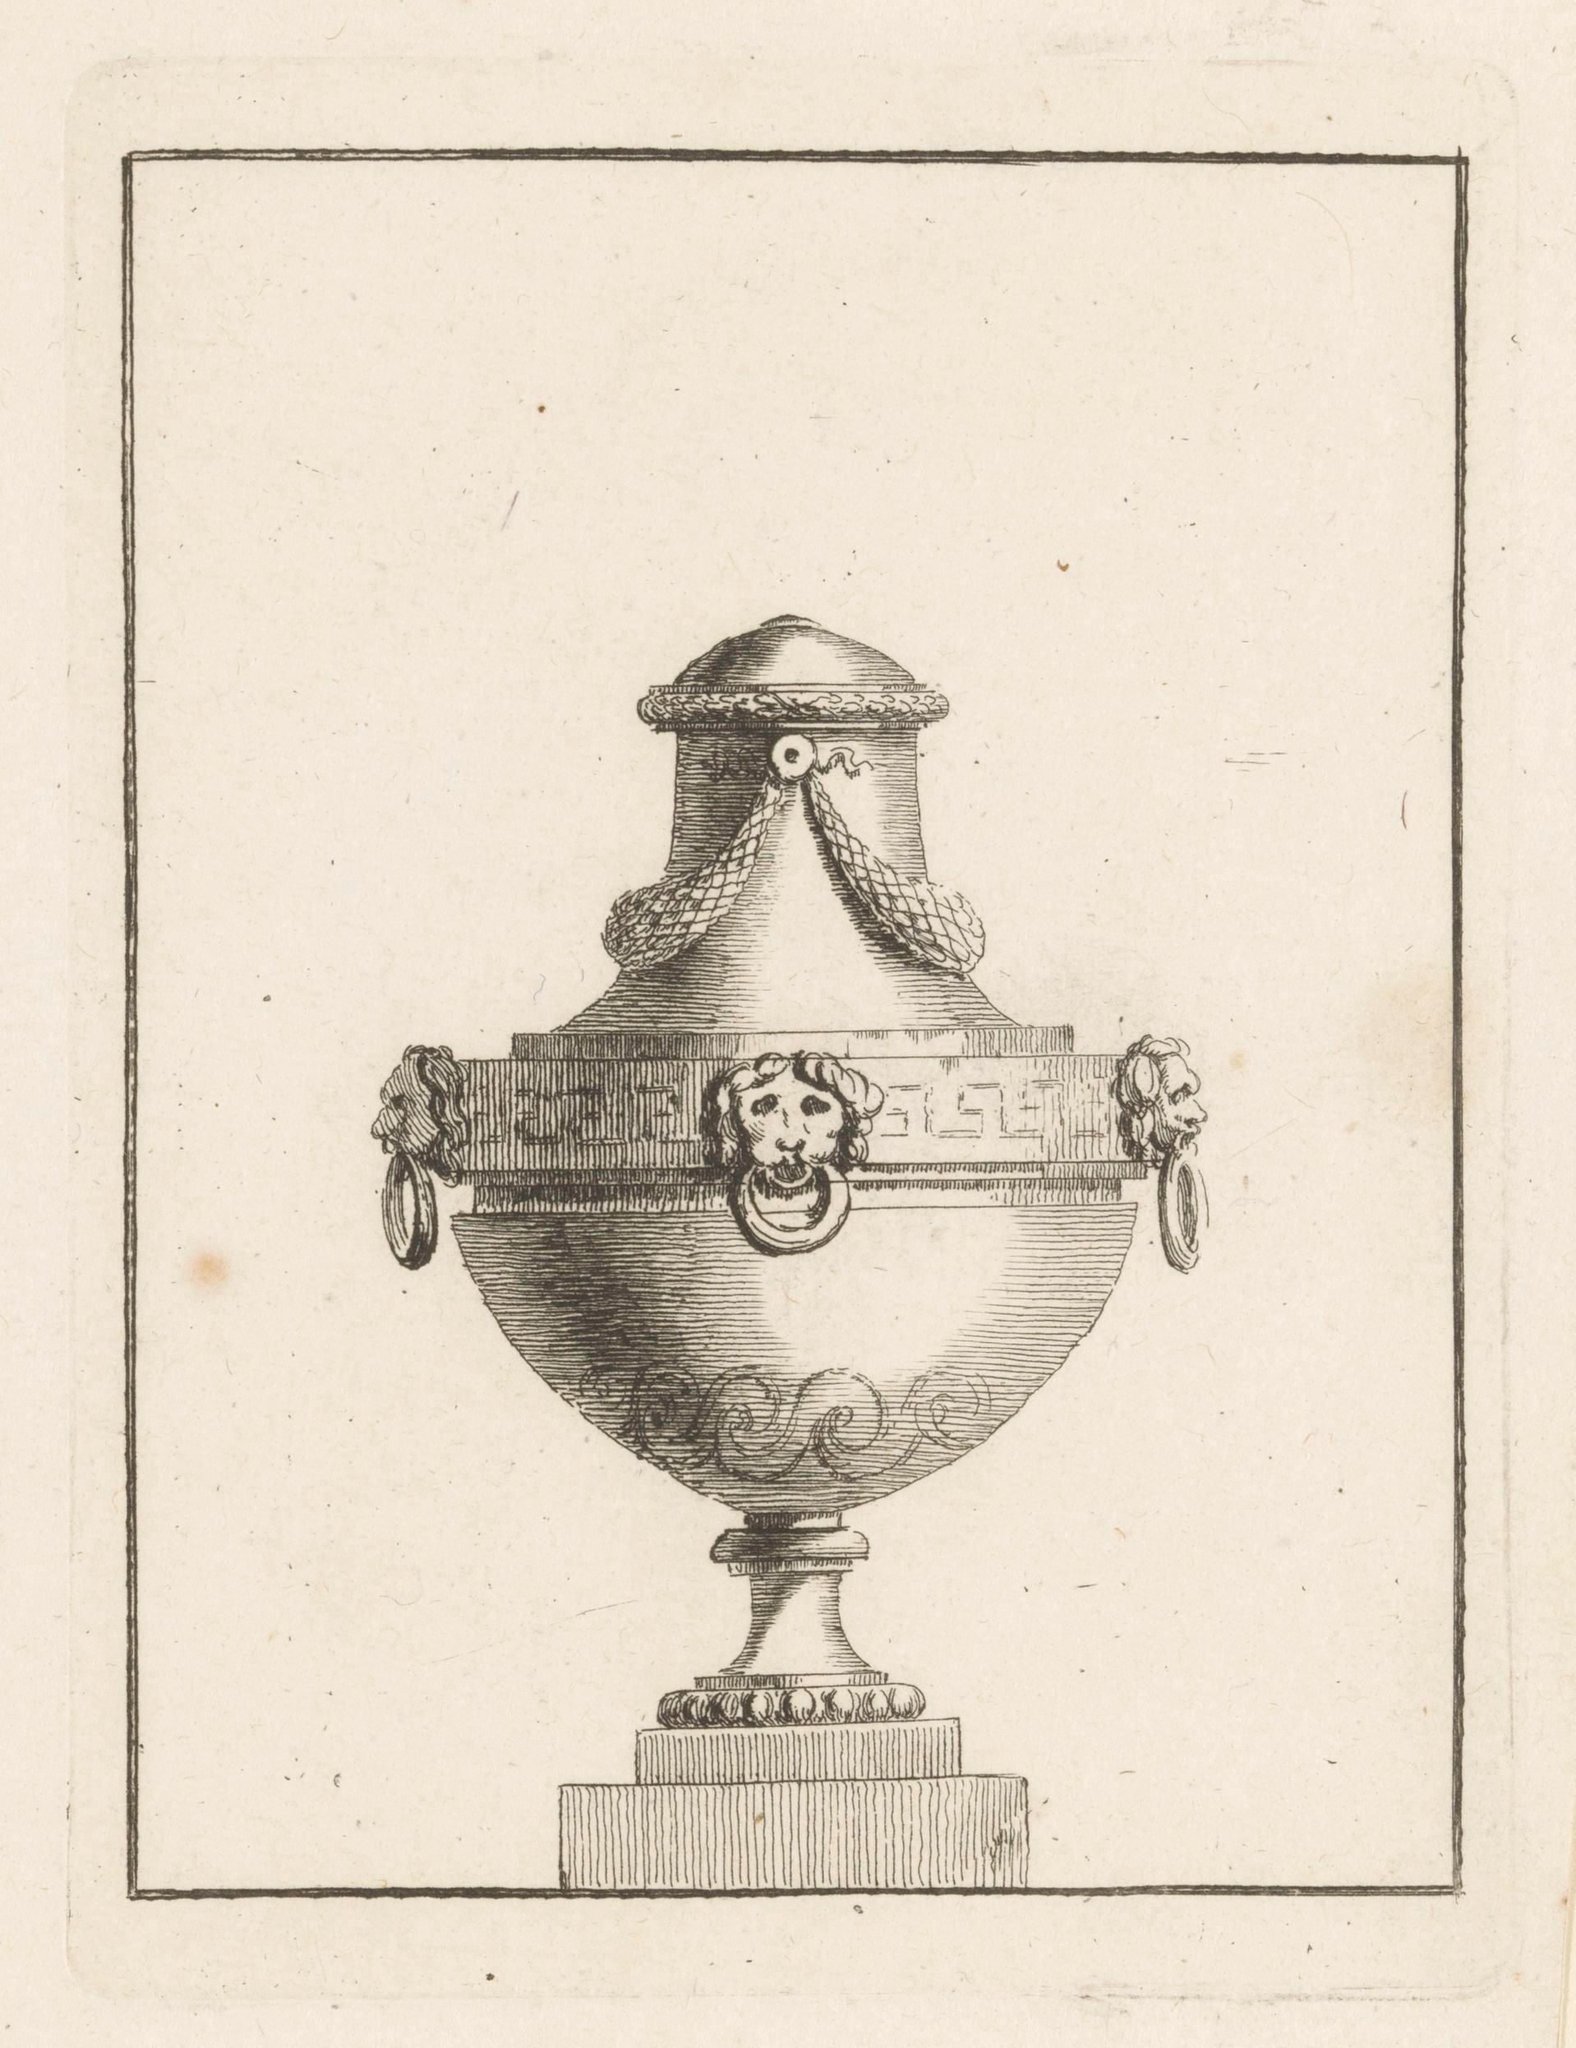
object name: ornament print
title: Vaas met leeuwenkoppen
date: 1755-1782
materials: paper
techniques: etching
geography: paris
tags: lion's head ~ ornament, vase ~ ornament, ornament ~ festoon, garland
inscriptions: collector's mark: Lugt 2228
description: Deze prent is onderdeel van een serie van acht.